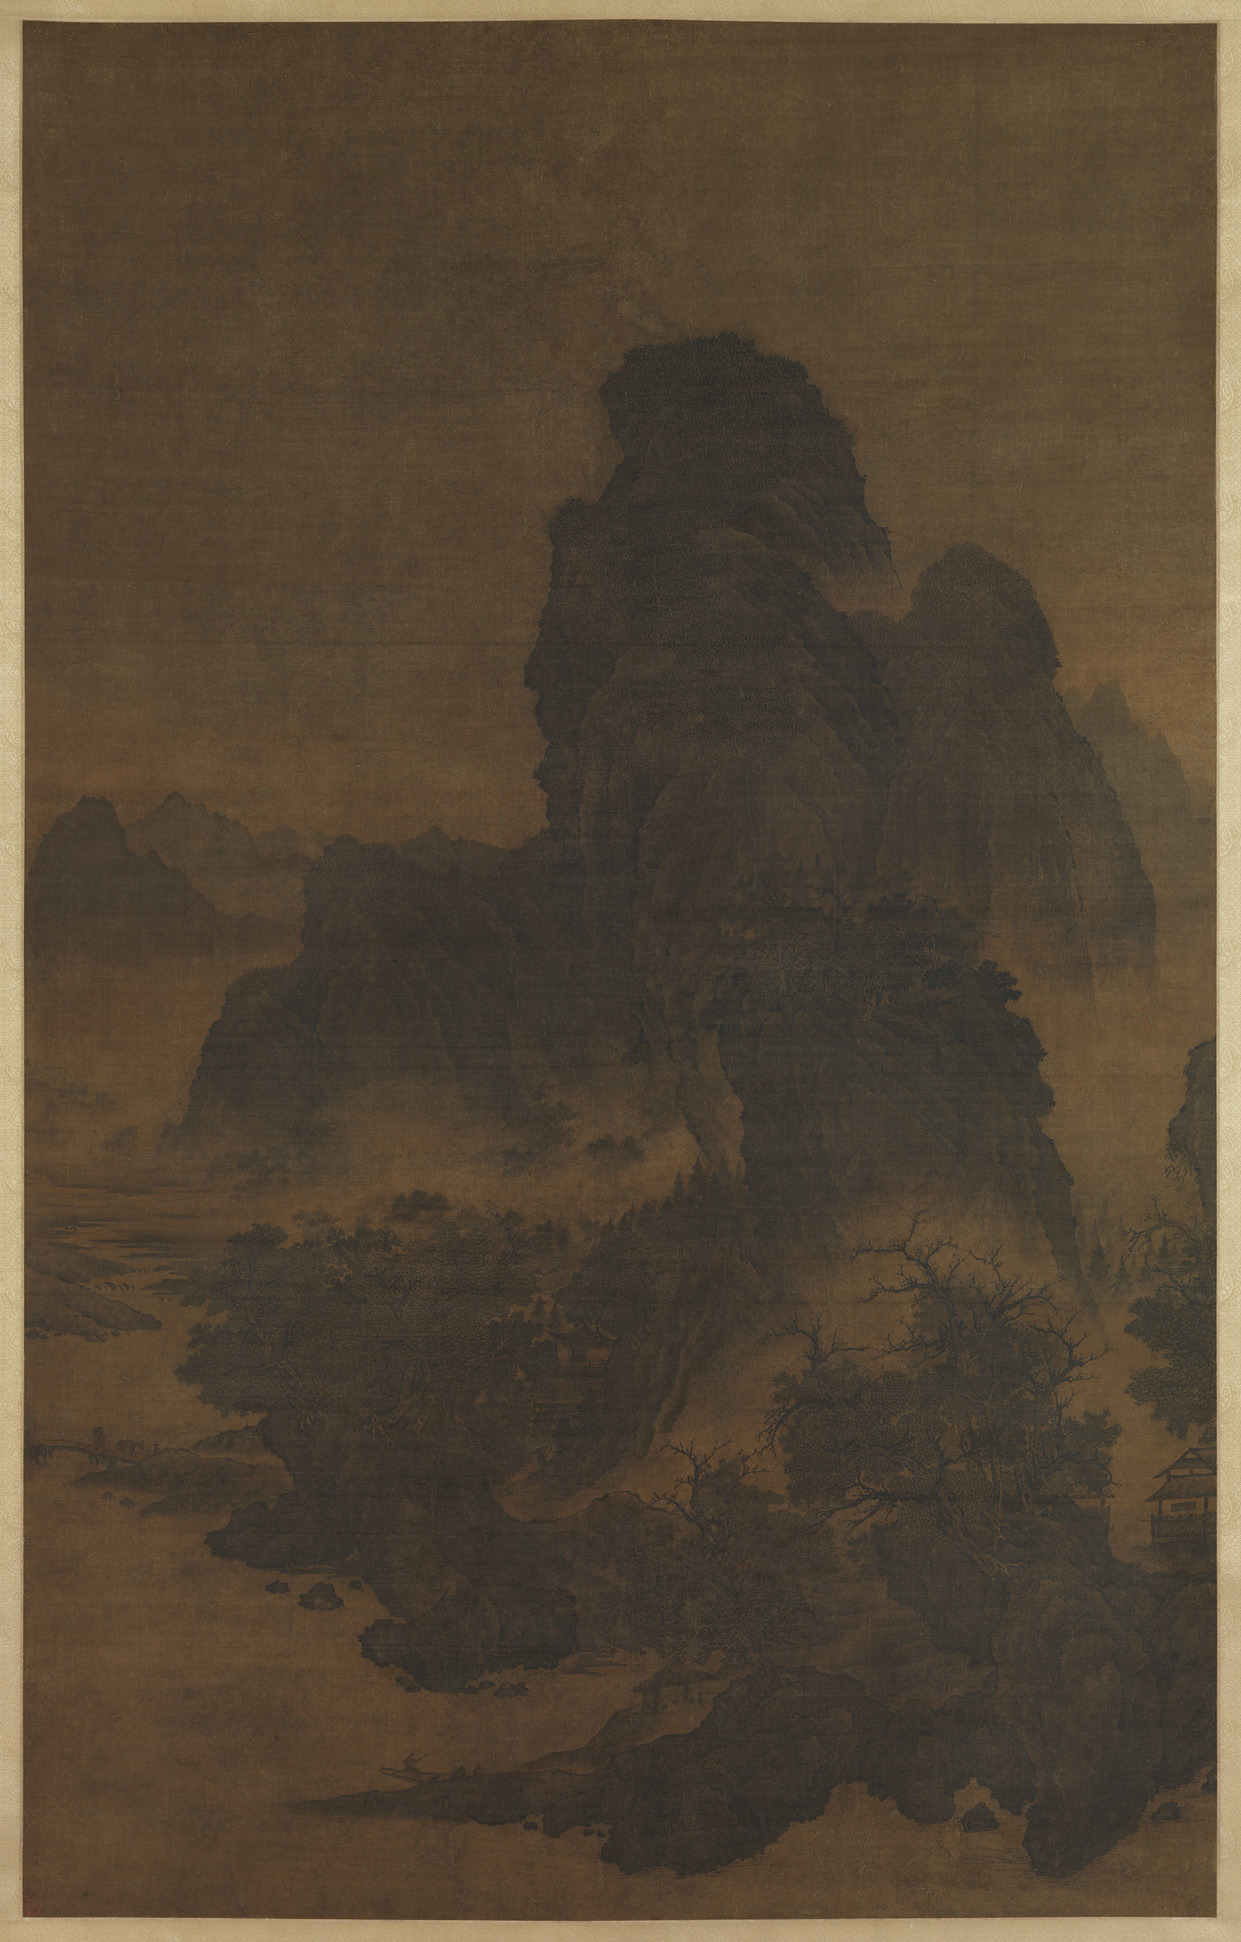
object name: hanging scroll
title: Landscape in the style of Fan Kuan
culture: chinese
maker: unidentified artist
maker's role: artist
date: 1101-1133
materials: ink, silk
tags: mountains,landscapes